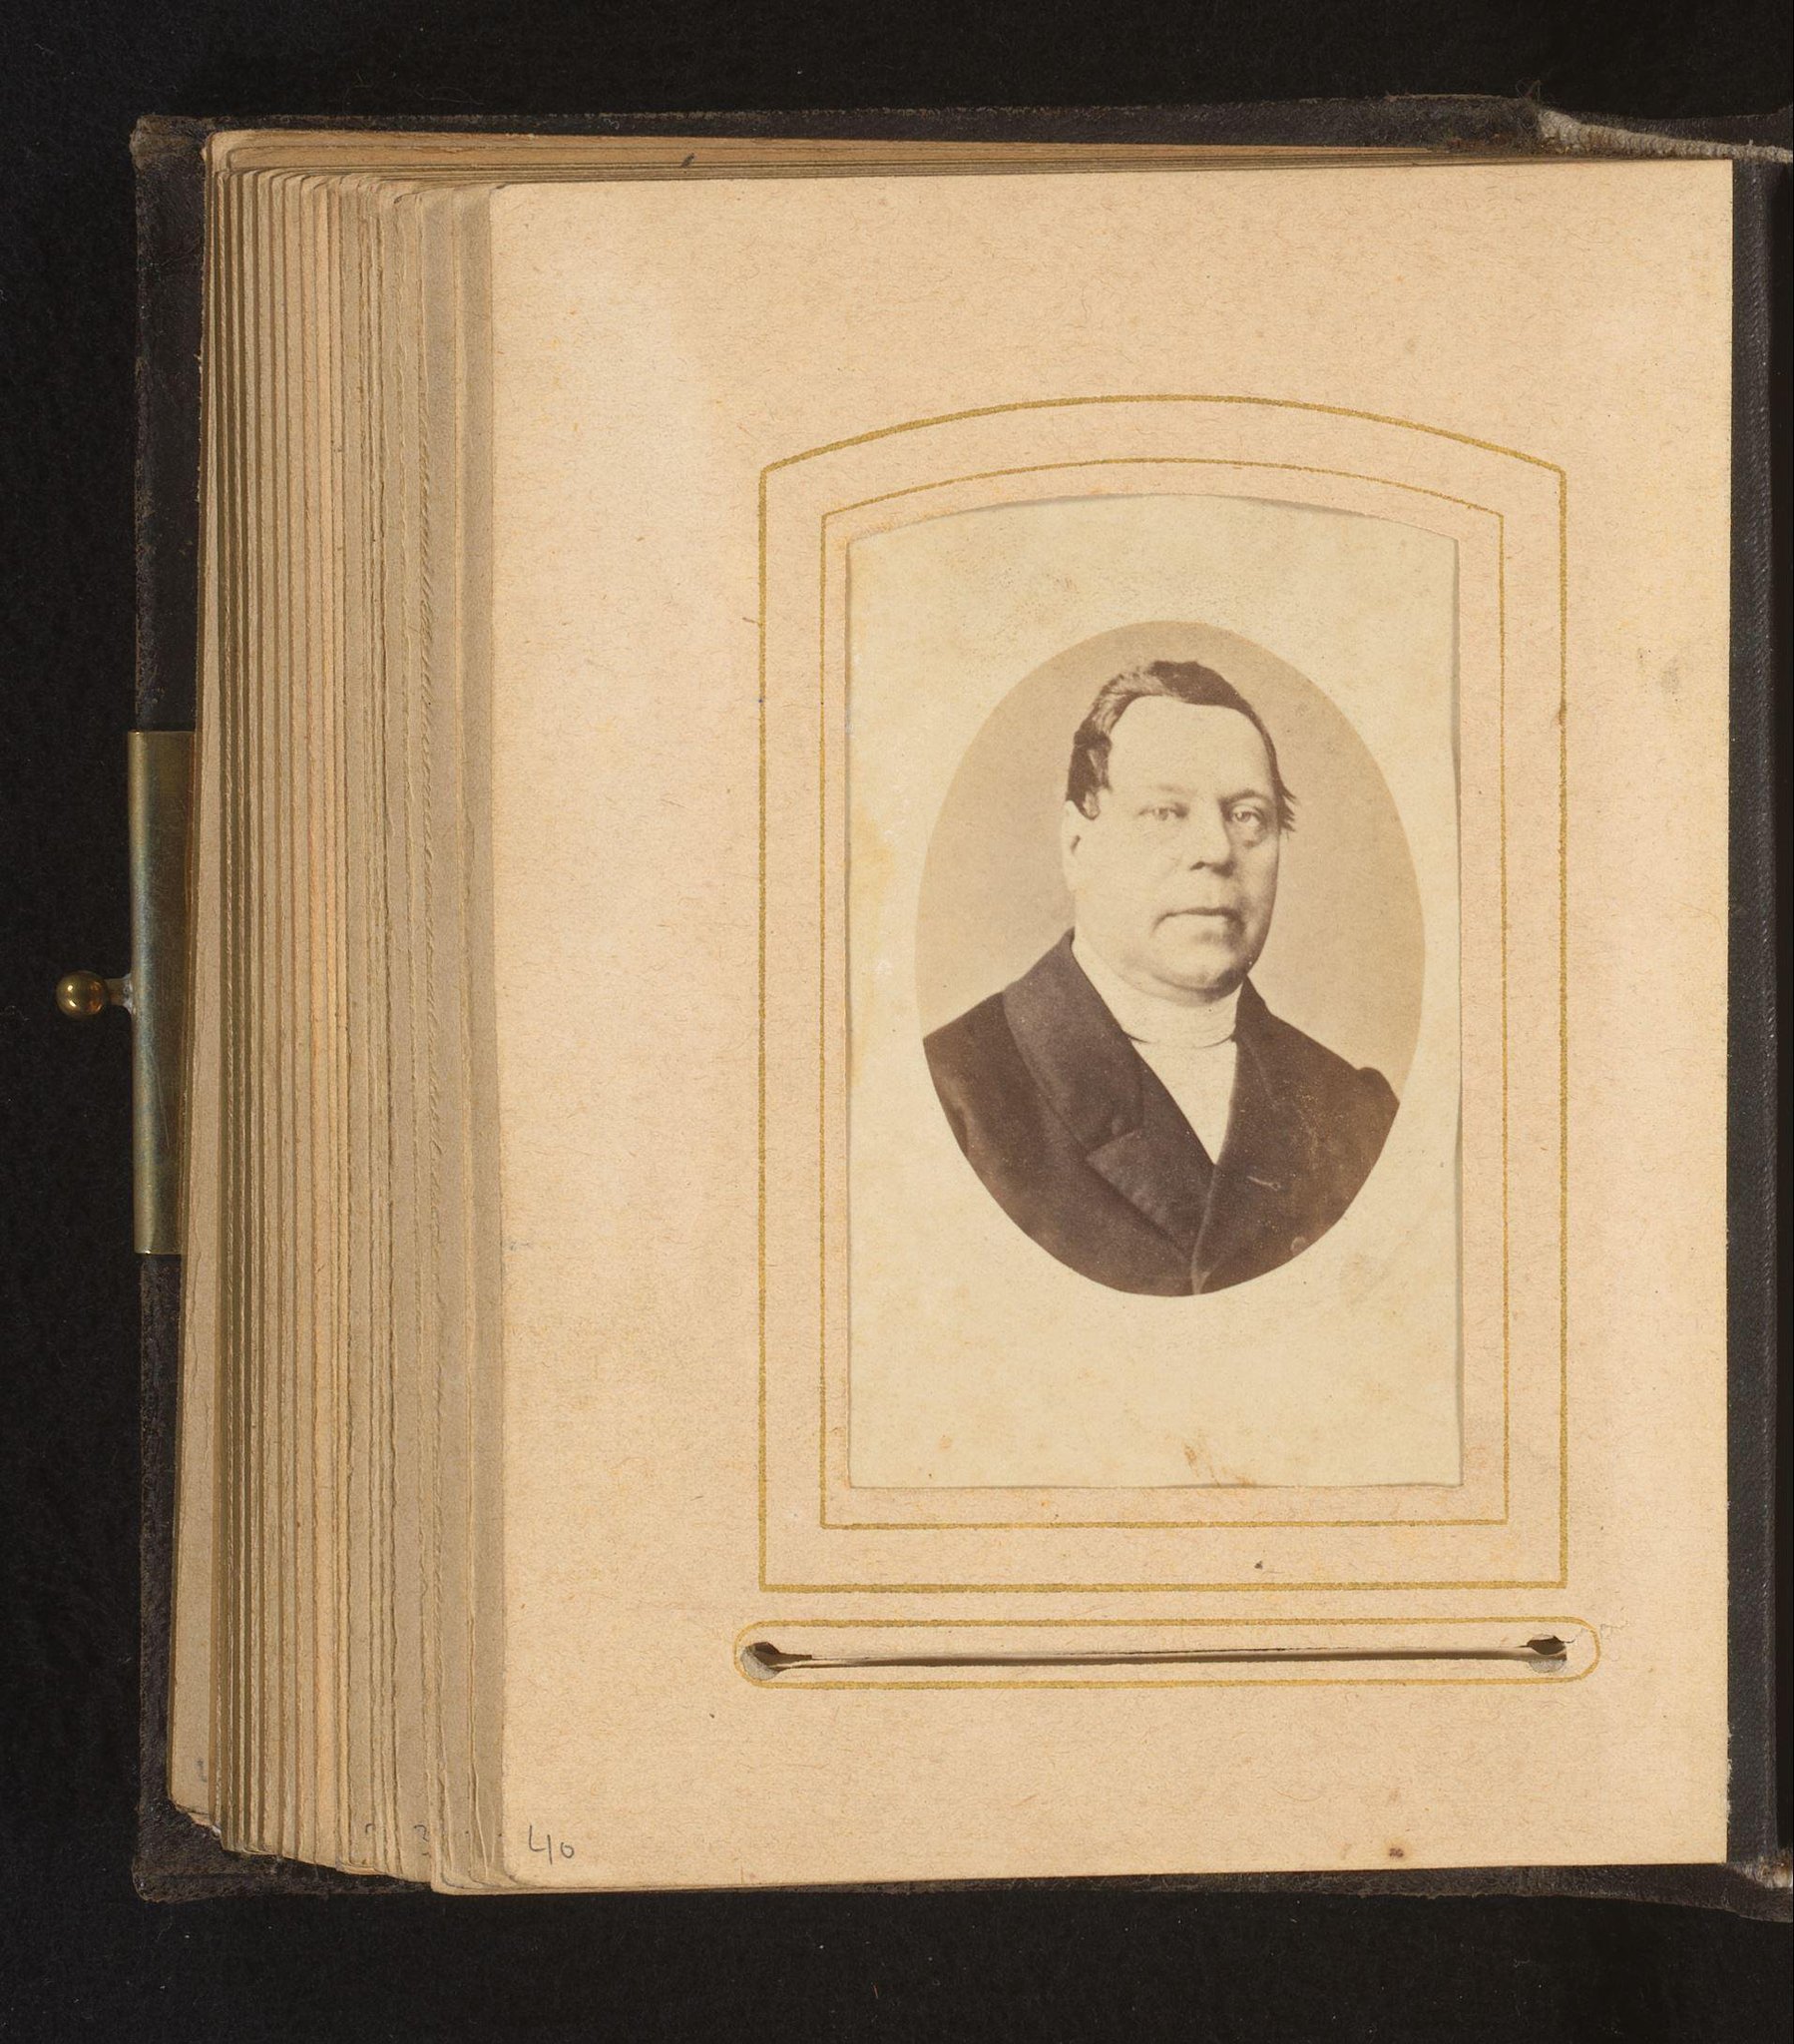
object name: carte de visite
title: Portret van een man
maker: Anonymous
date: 1860-1890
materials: cardboard, photographic support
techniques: albumen print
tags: historical persons